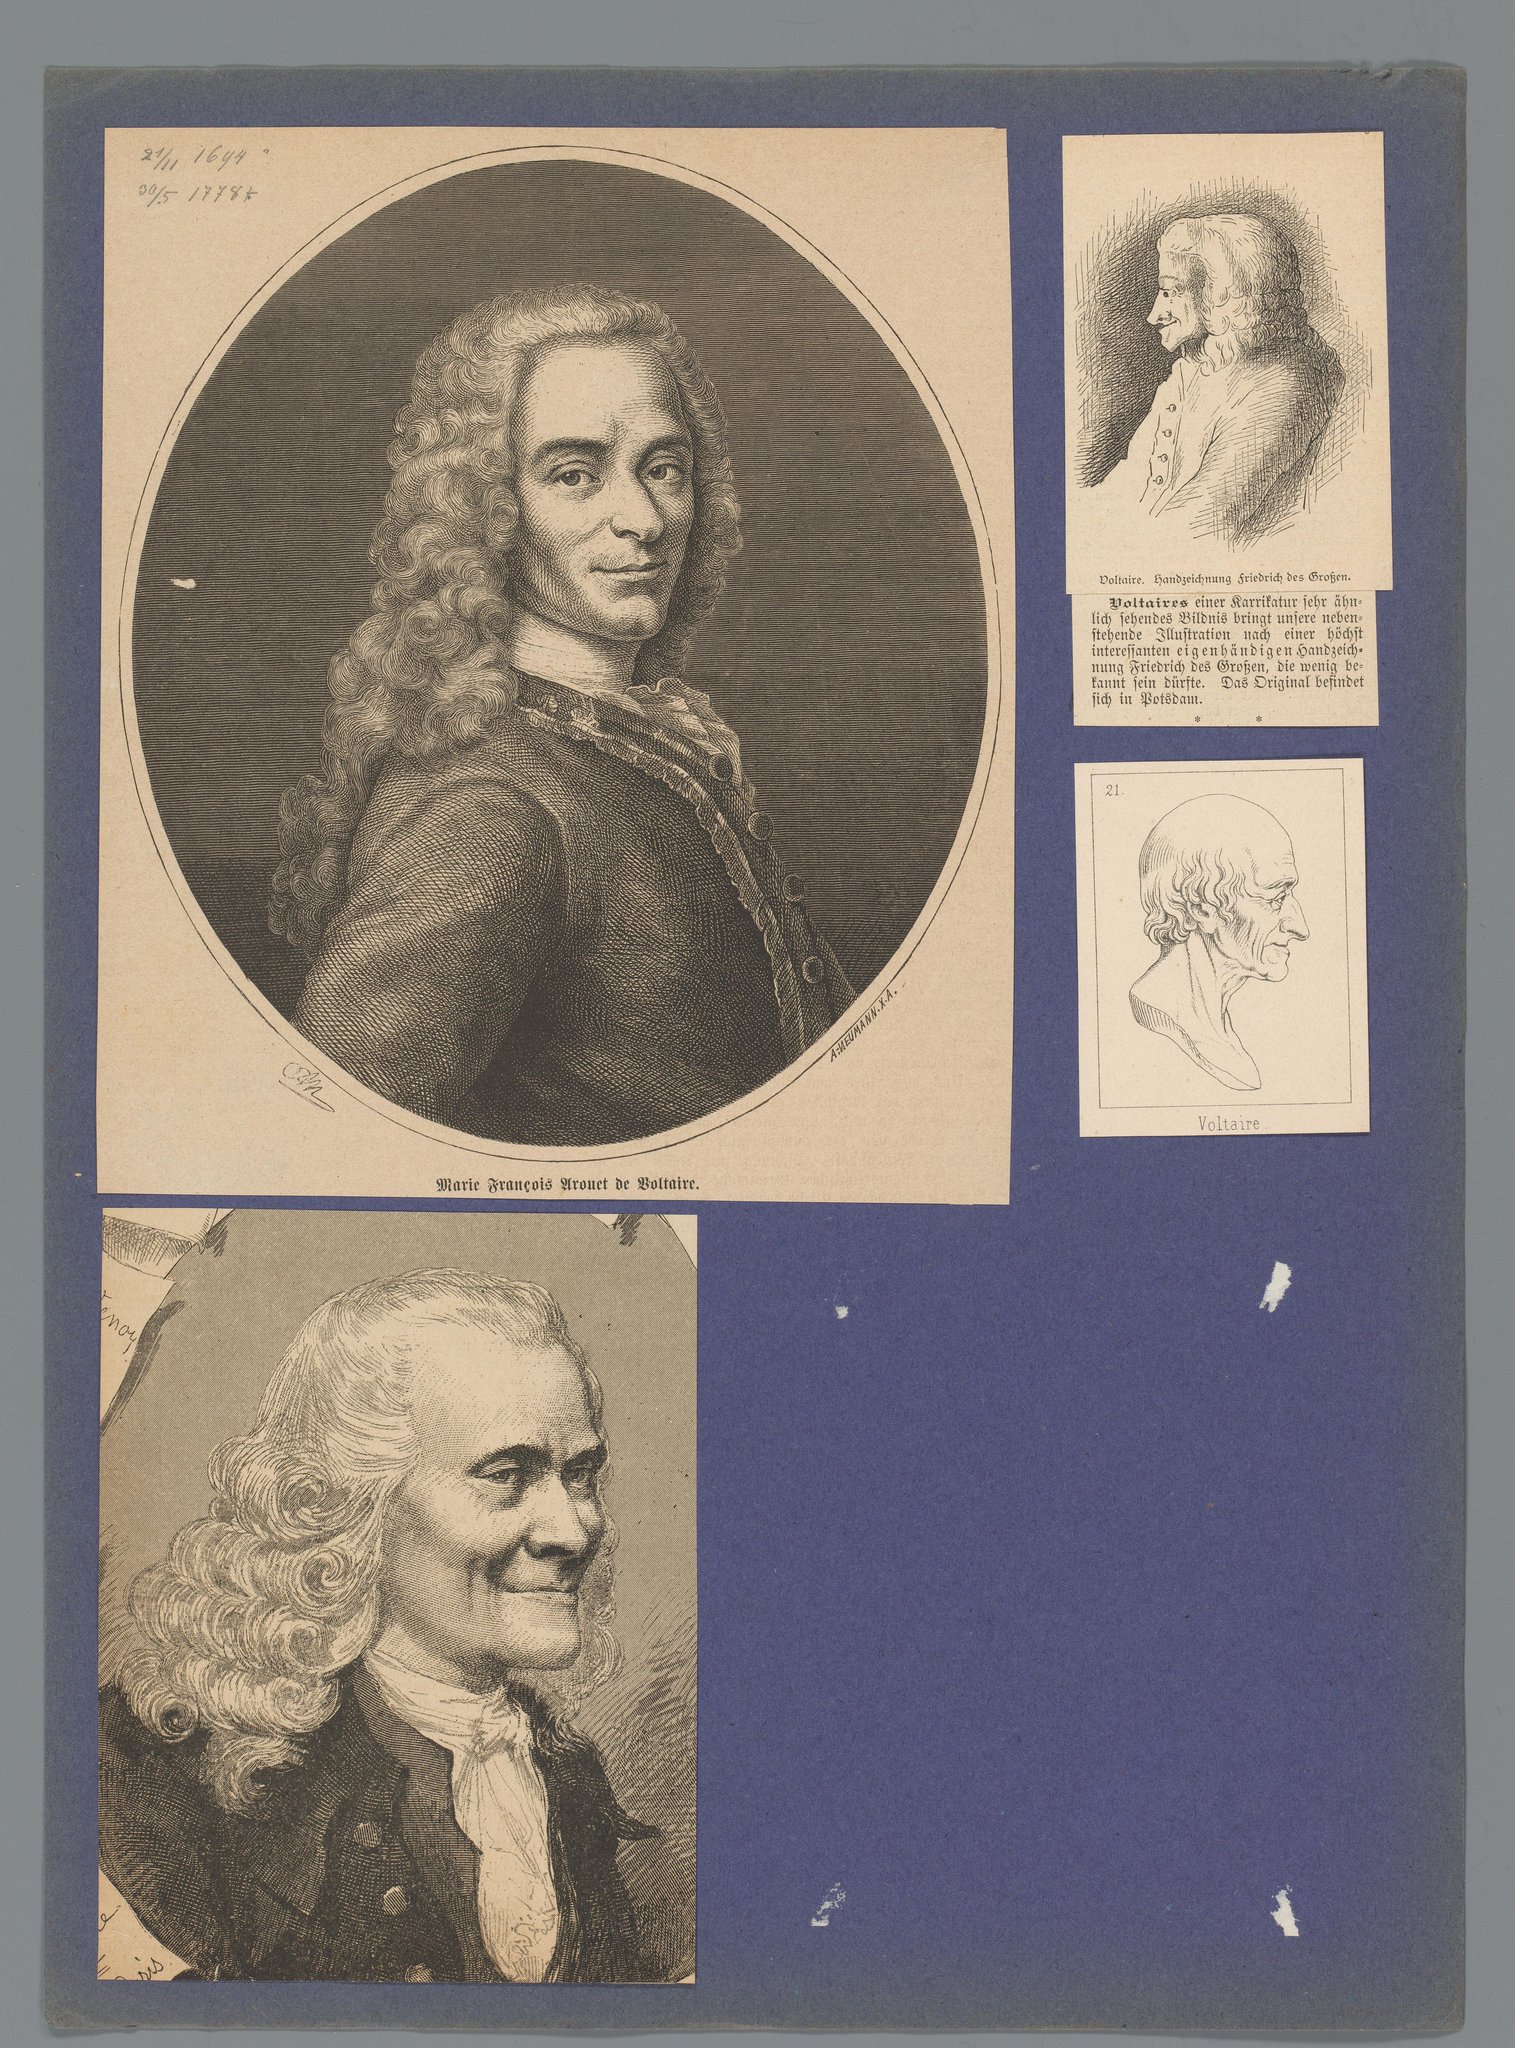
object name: sheet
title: Blad met vier portretten van Voltaire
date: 1850-1900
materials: paper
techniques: letterpress printing, snipping, engraving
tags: paris, voltaire, historical persons, portrait of a writer, scholar, philosopher (+ portrait of scholar, scientist)